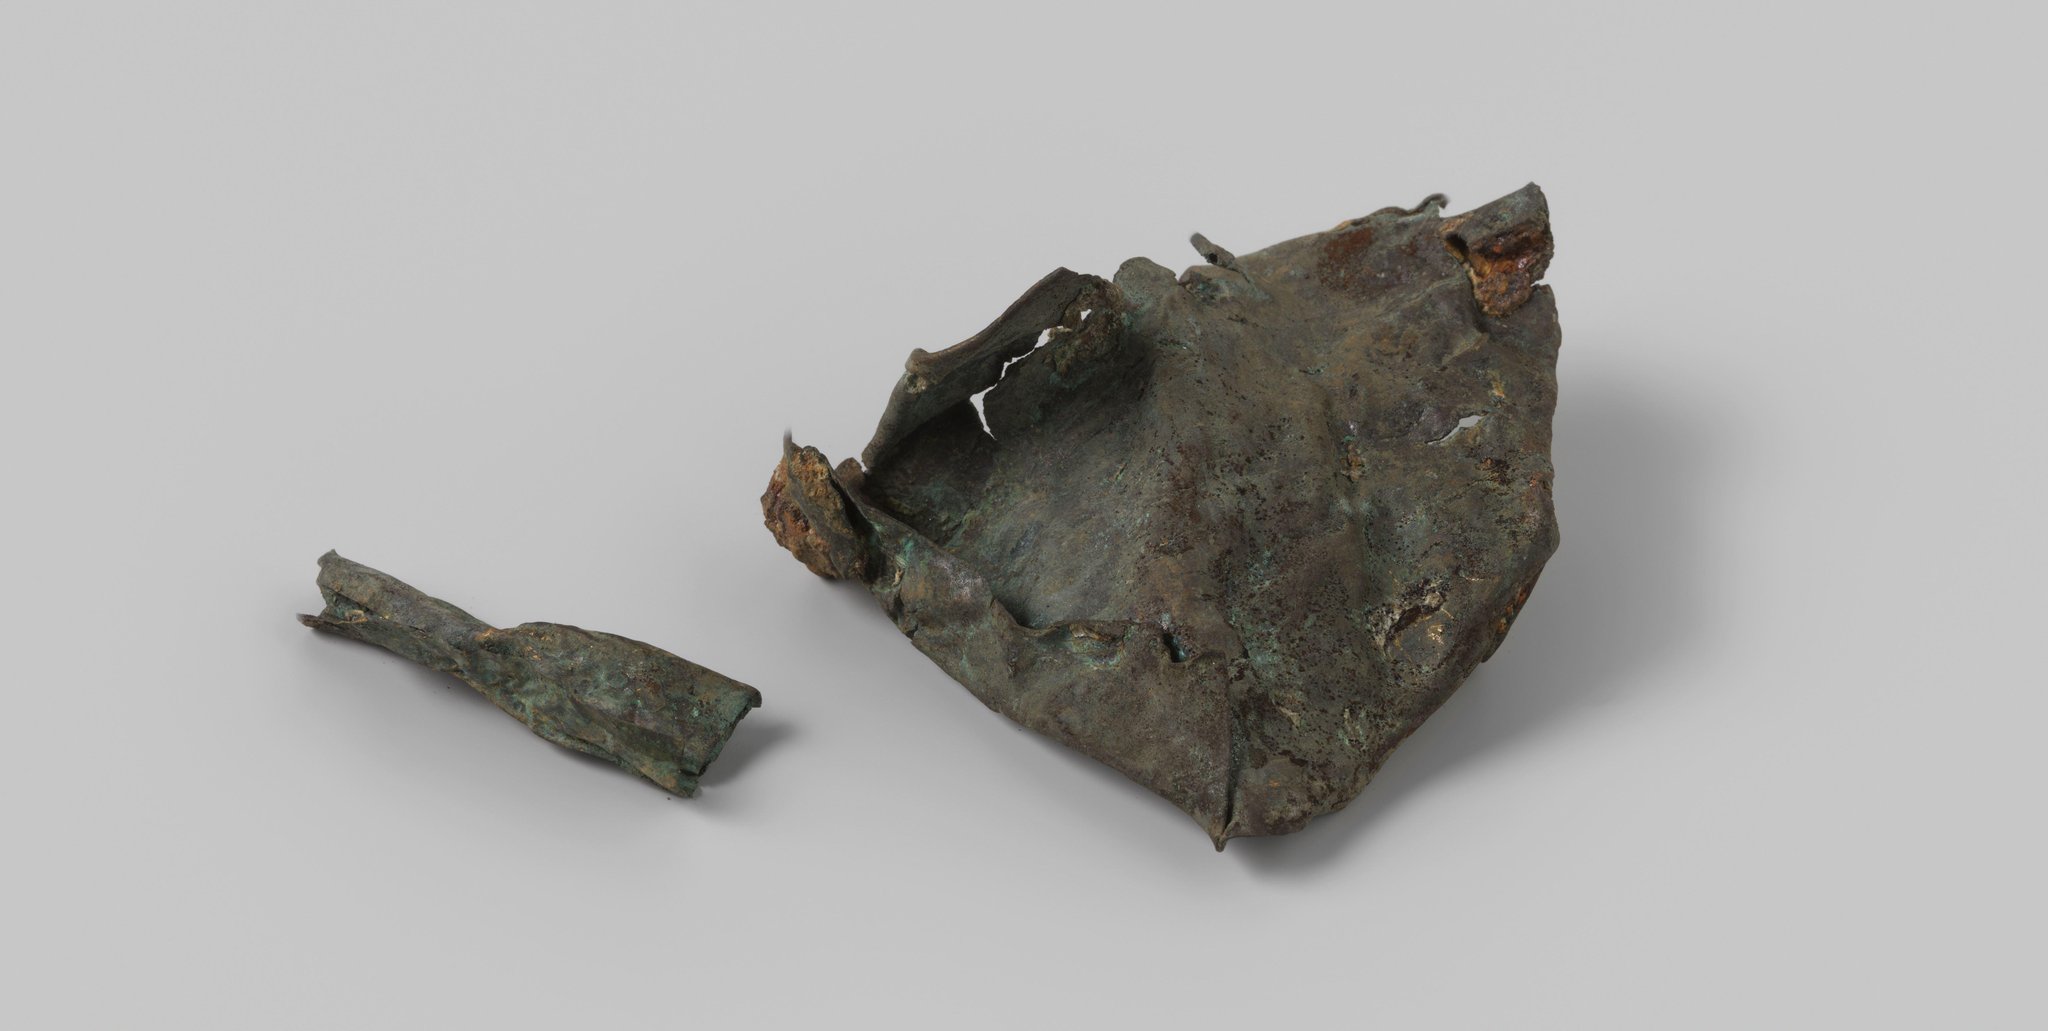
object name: cartridge shell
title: Fragmenten patroonhuls uit het wrak van de Oost-Indiëvaarder Hollandia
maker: Anonymous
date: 1700-1743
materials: copper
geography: netherlands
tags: verenigde oostindische compagnie, hollandia (schip), annet